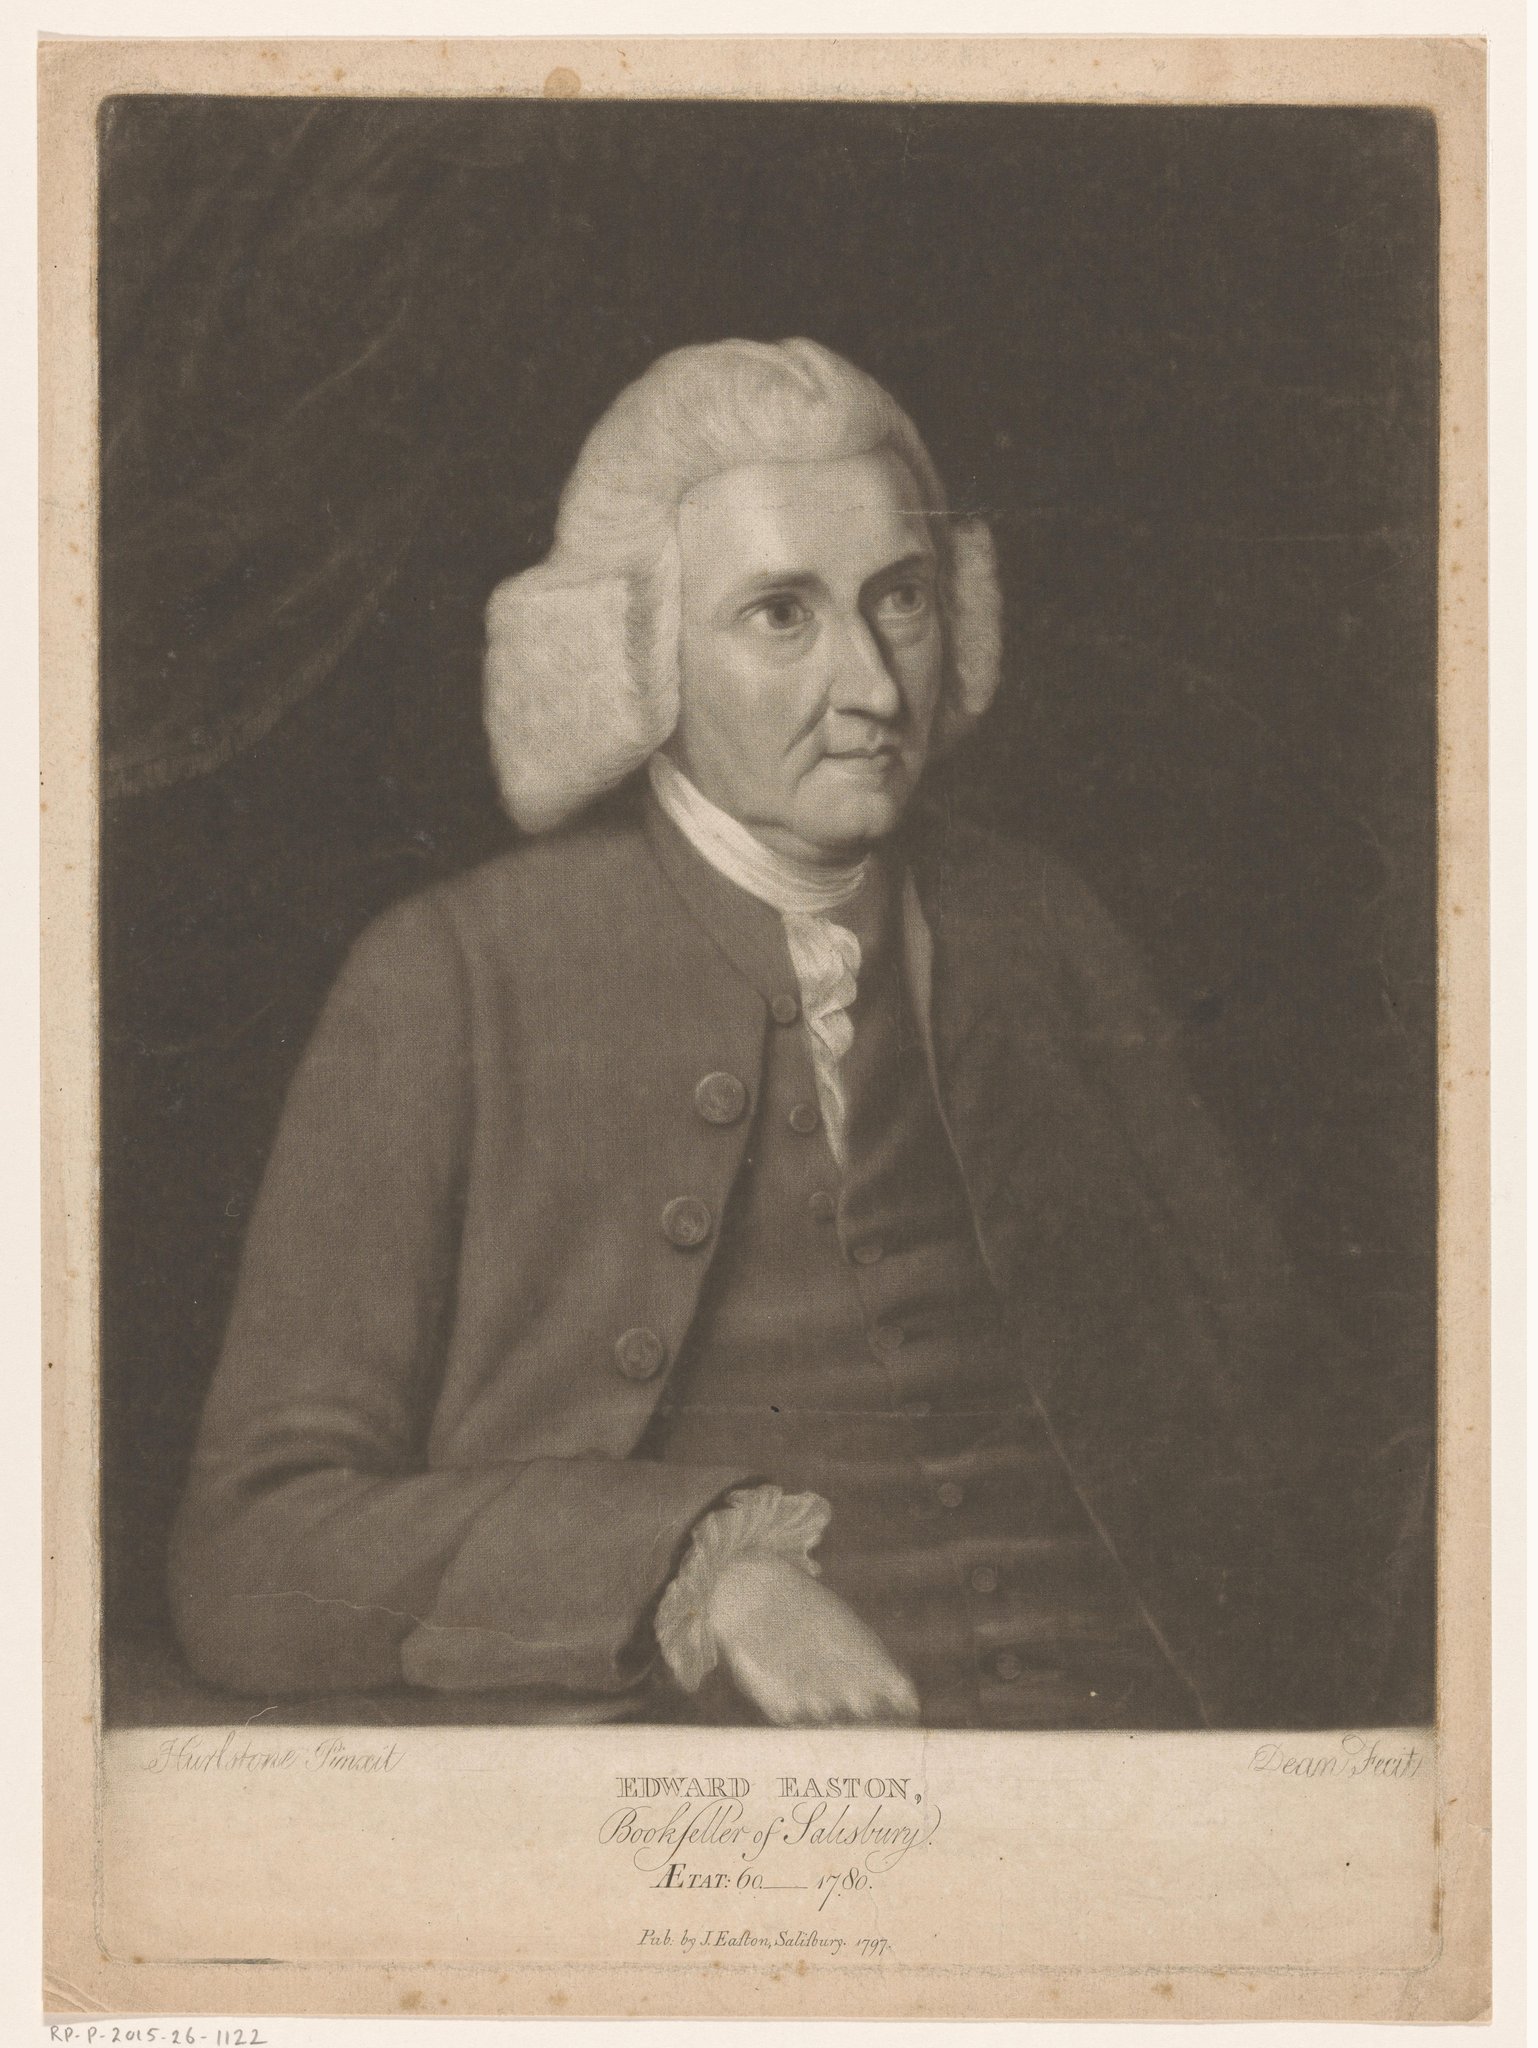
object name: print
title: Edward Easton, Bookseller of Sailsbury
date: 1797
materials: paper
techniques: mezzotint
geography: salisbury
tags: printer, publisher, book-shop, bookseller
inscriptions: collector's mark